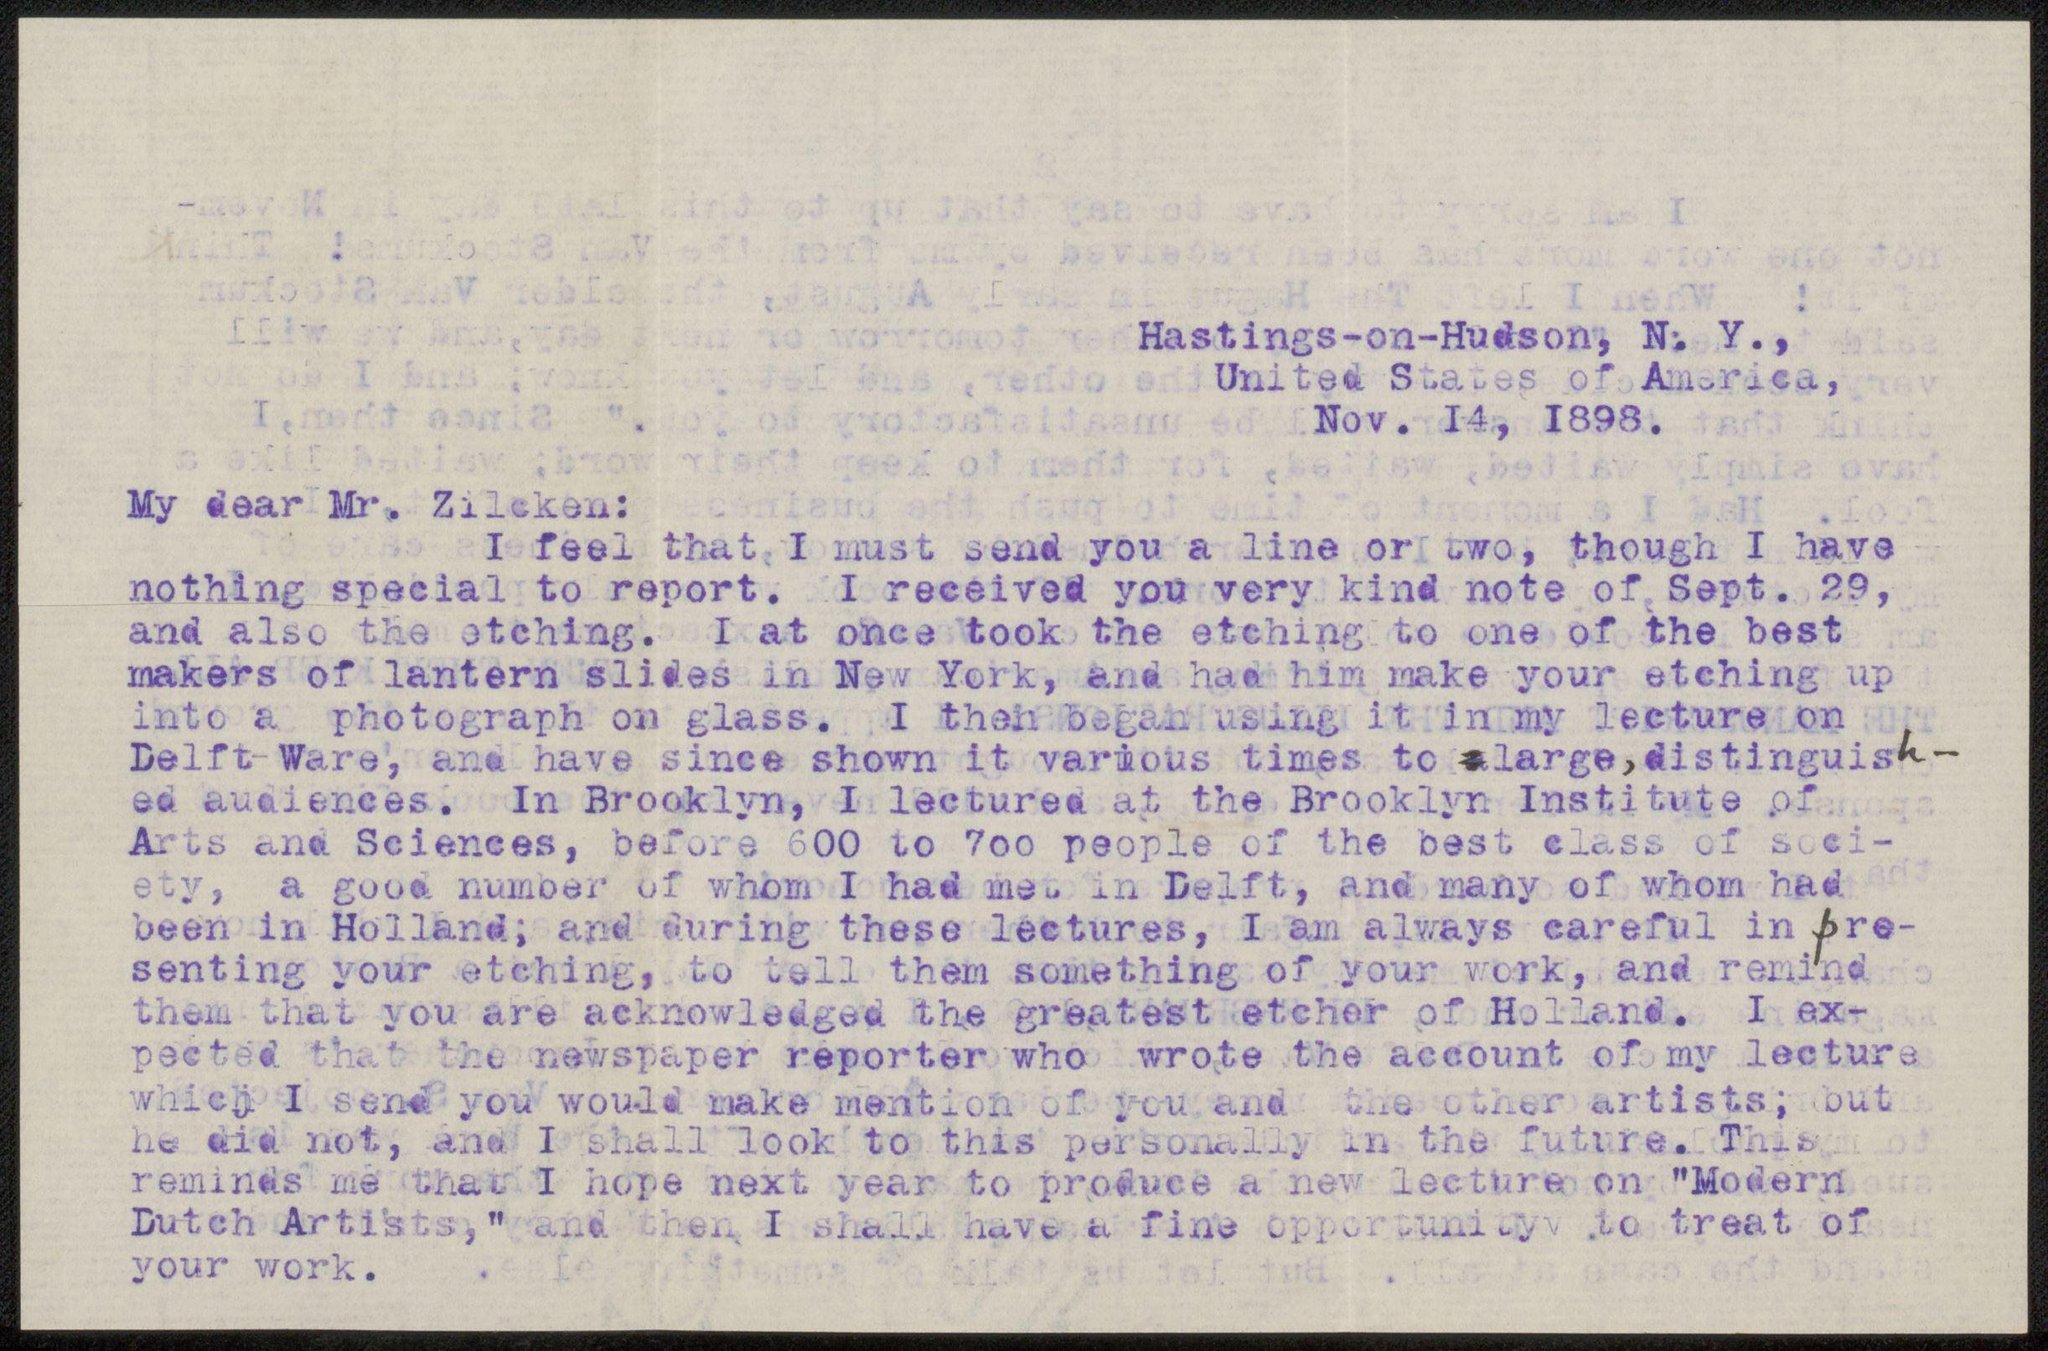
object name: letter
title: Brief aan Philip Zilcken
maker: j. perry worden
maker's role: historicus, journalist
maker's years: 1866-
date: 1898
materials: ink, paper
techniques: pen, typewriting, writing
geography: hastings-on-hudson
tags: painter, draughtsman, philip zilcken, photography, cinematography, the graphic arts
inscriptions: watermark, collector's mark: ‘RPK’